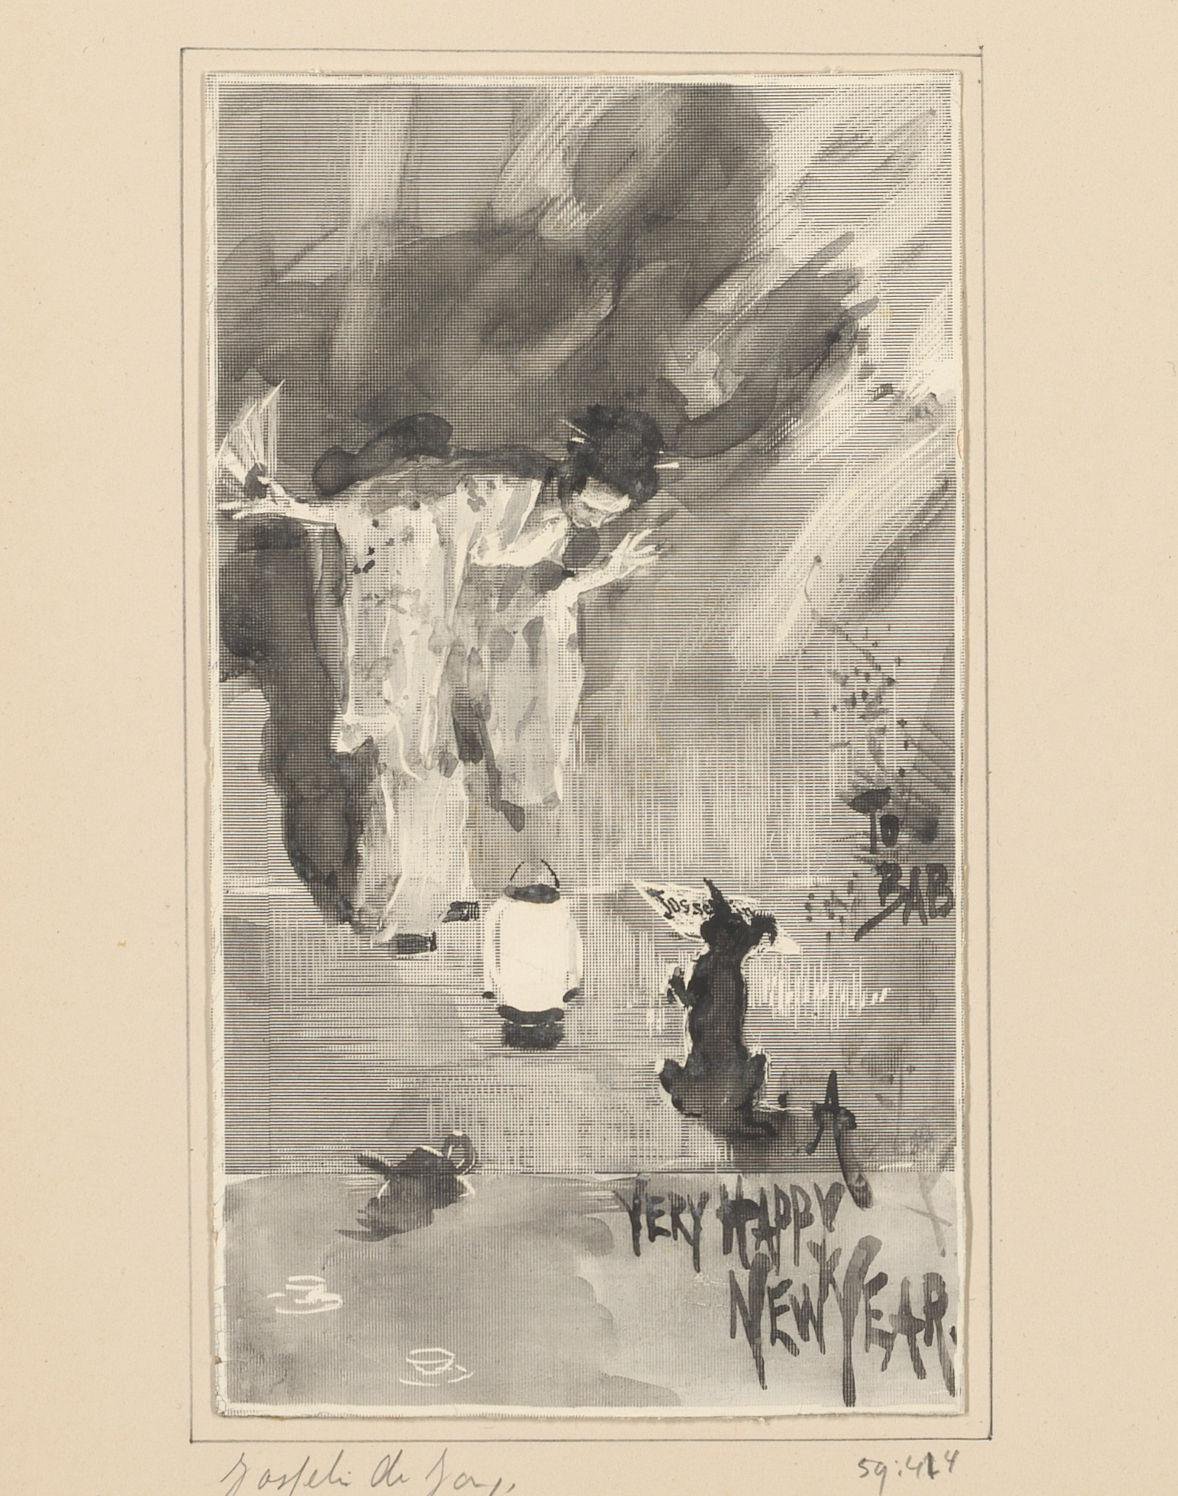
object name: drawing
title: Nieuwjaarskaart met Japanse vrouw met lampion en hond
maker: pieter de josselin de jong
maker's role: draughtsman, painter, print maker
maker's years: 1861-1906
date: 1871-1906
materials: cardboard, watercolor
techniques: brush, scratchboard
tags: adult woman, lantern, dog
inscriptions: inscription: ‘To Bab/ a very happy new year’